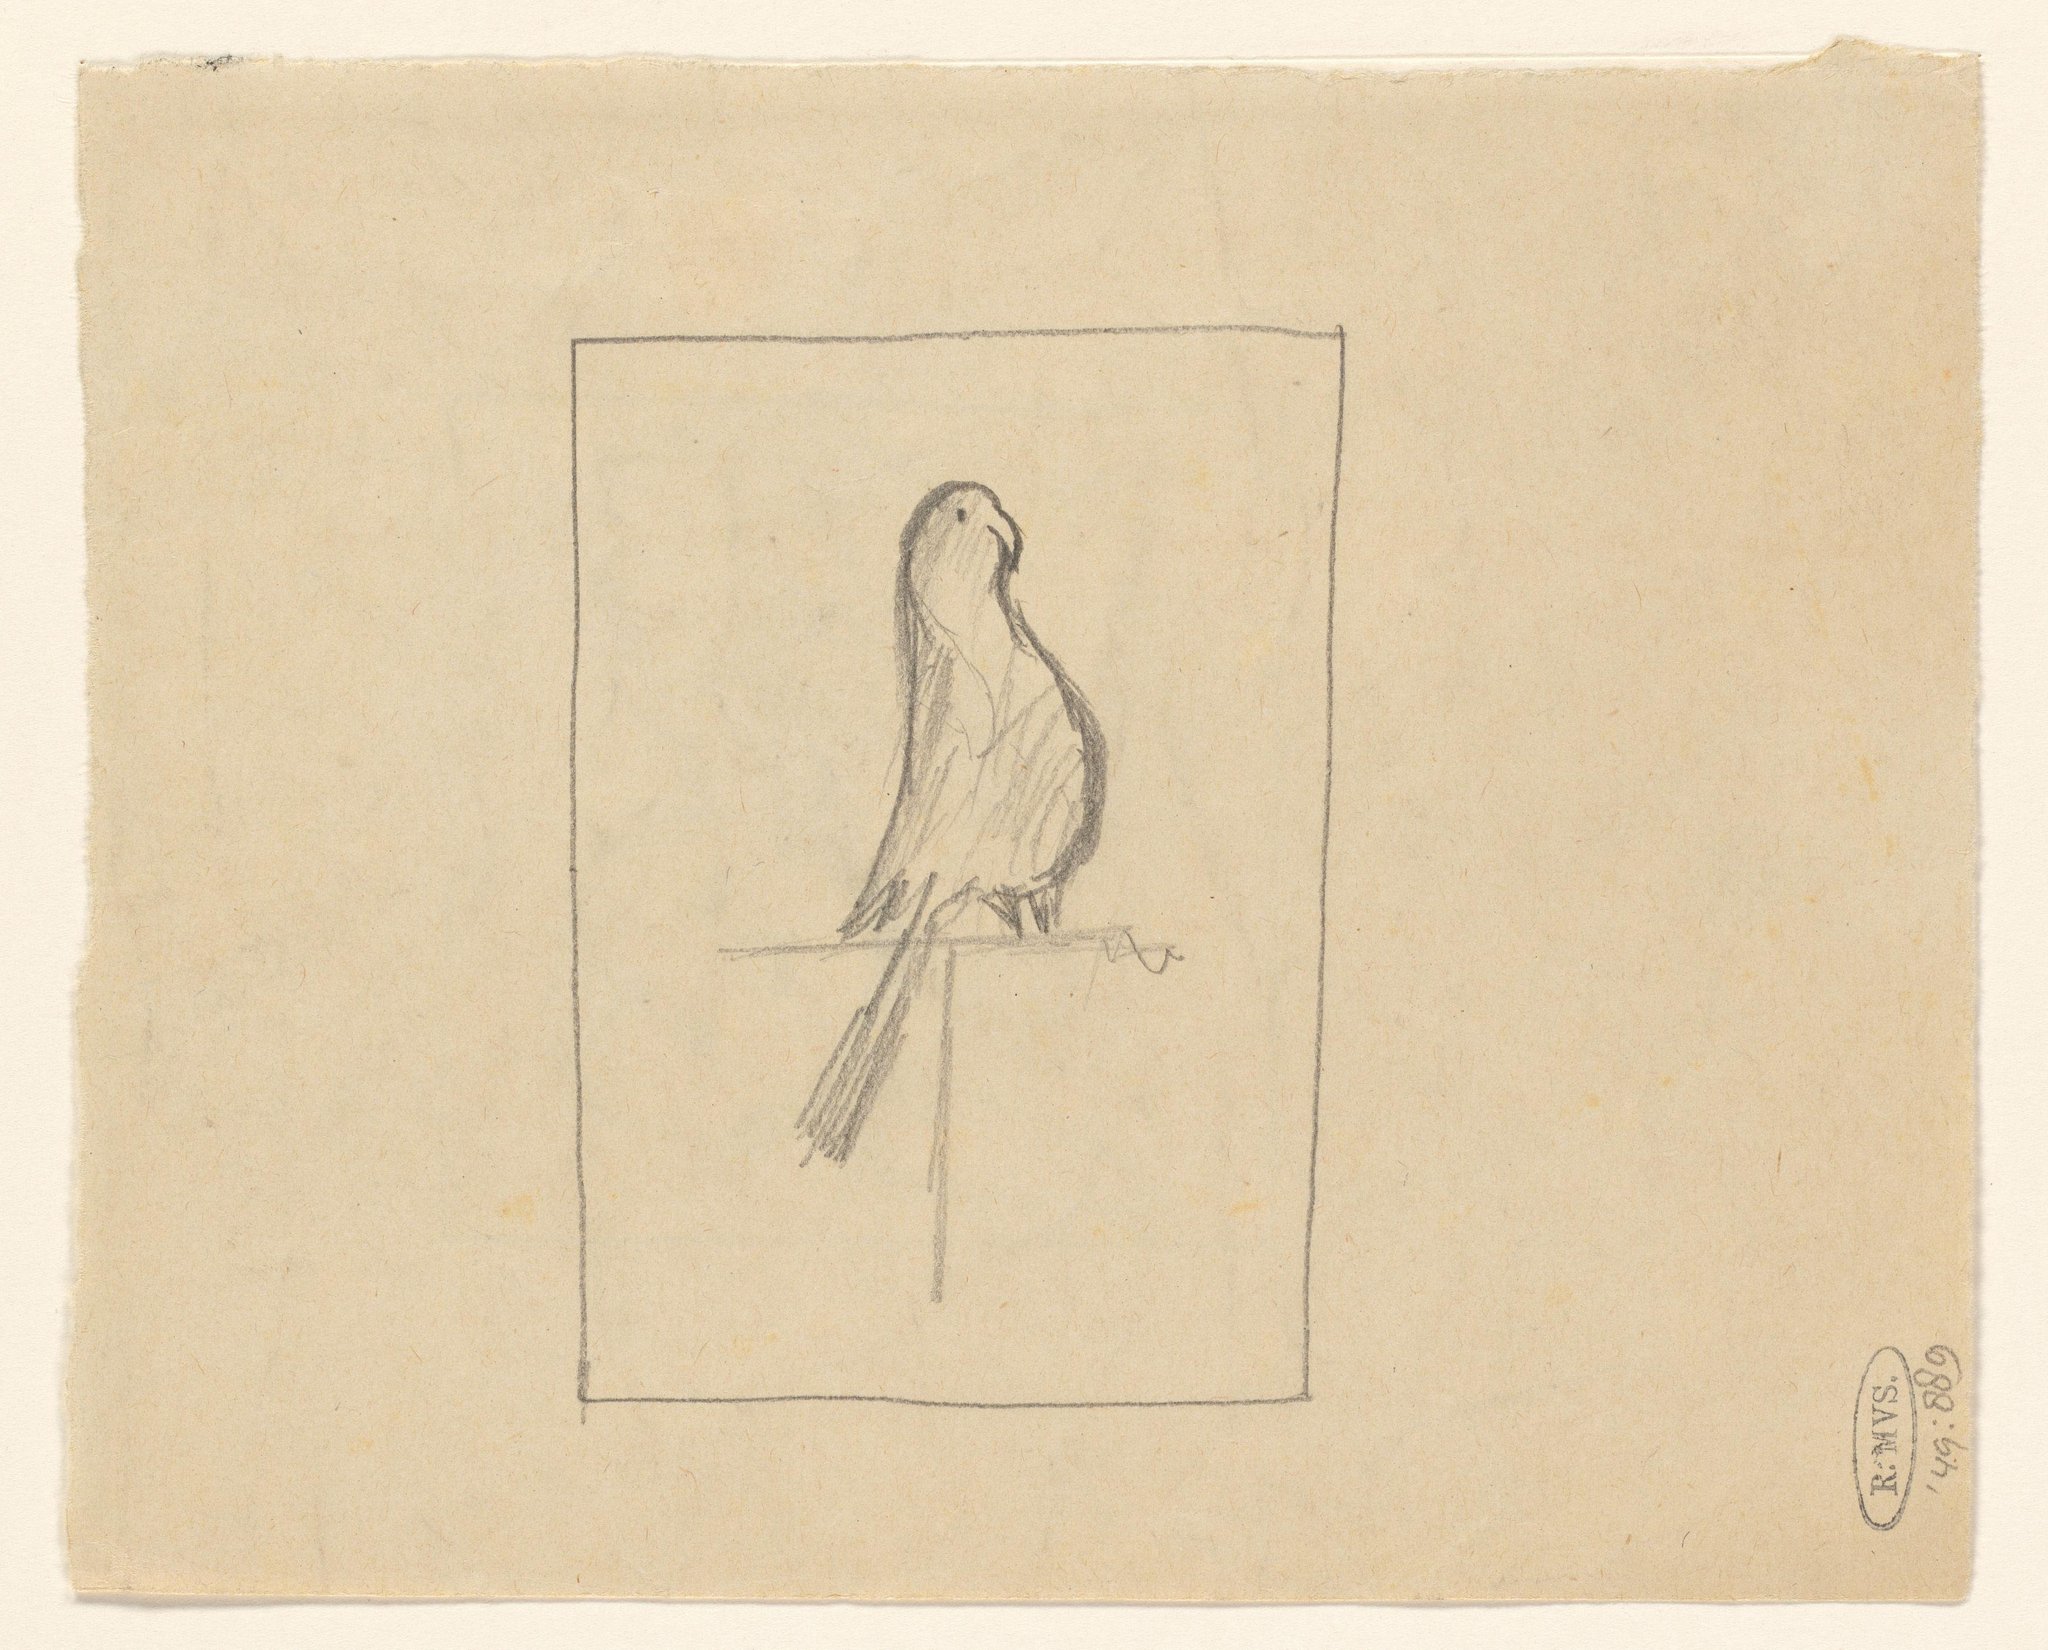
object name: drawing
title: Schets van een papegaai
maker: august allebé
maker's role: draughtsman, print maker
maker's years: 1838-1927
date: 1848-1927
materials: paper, pencil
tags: ornamental birds: parrot